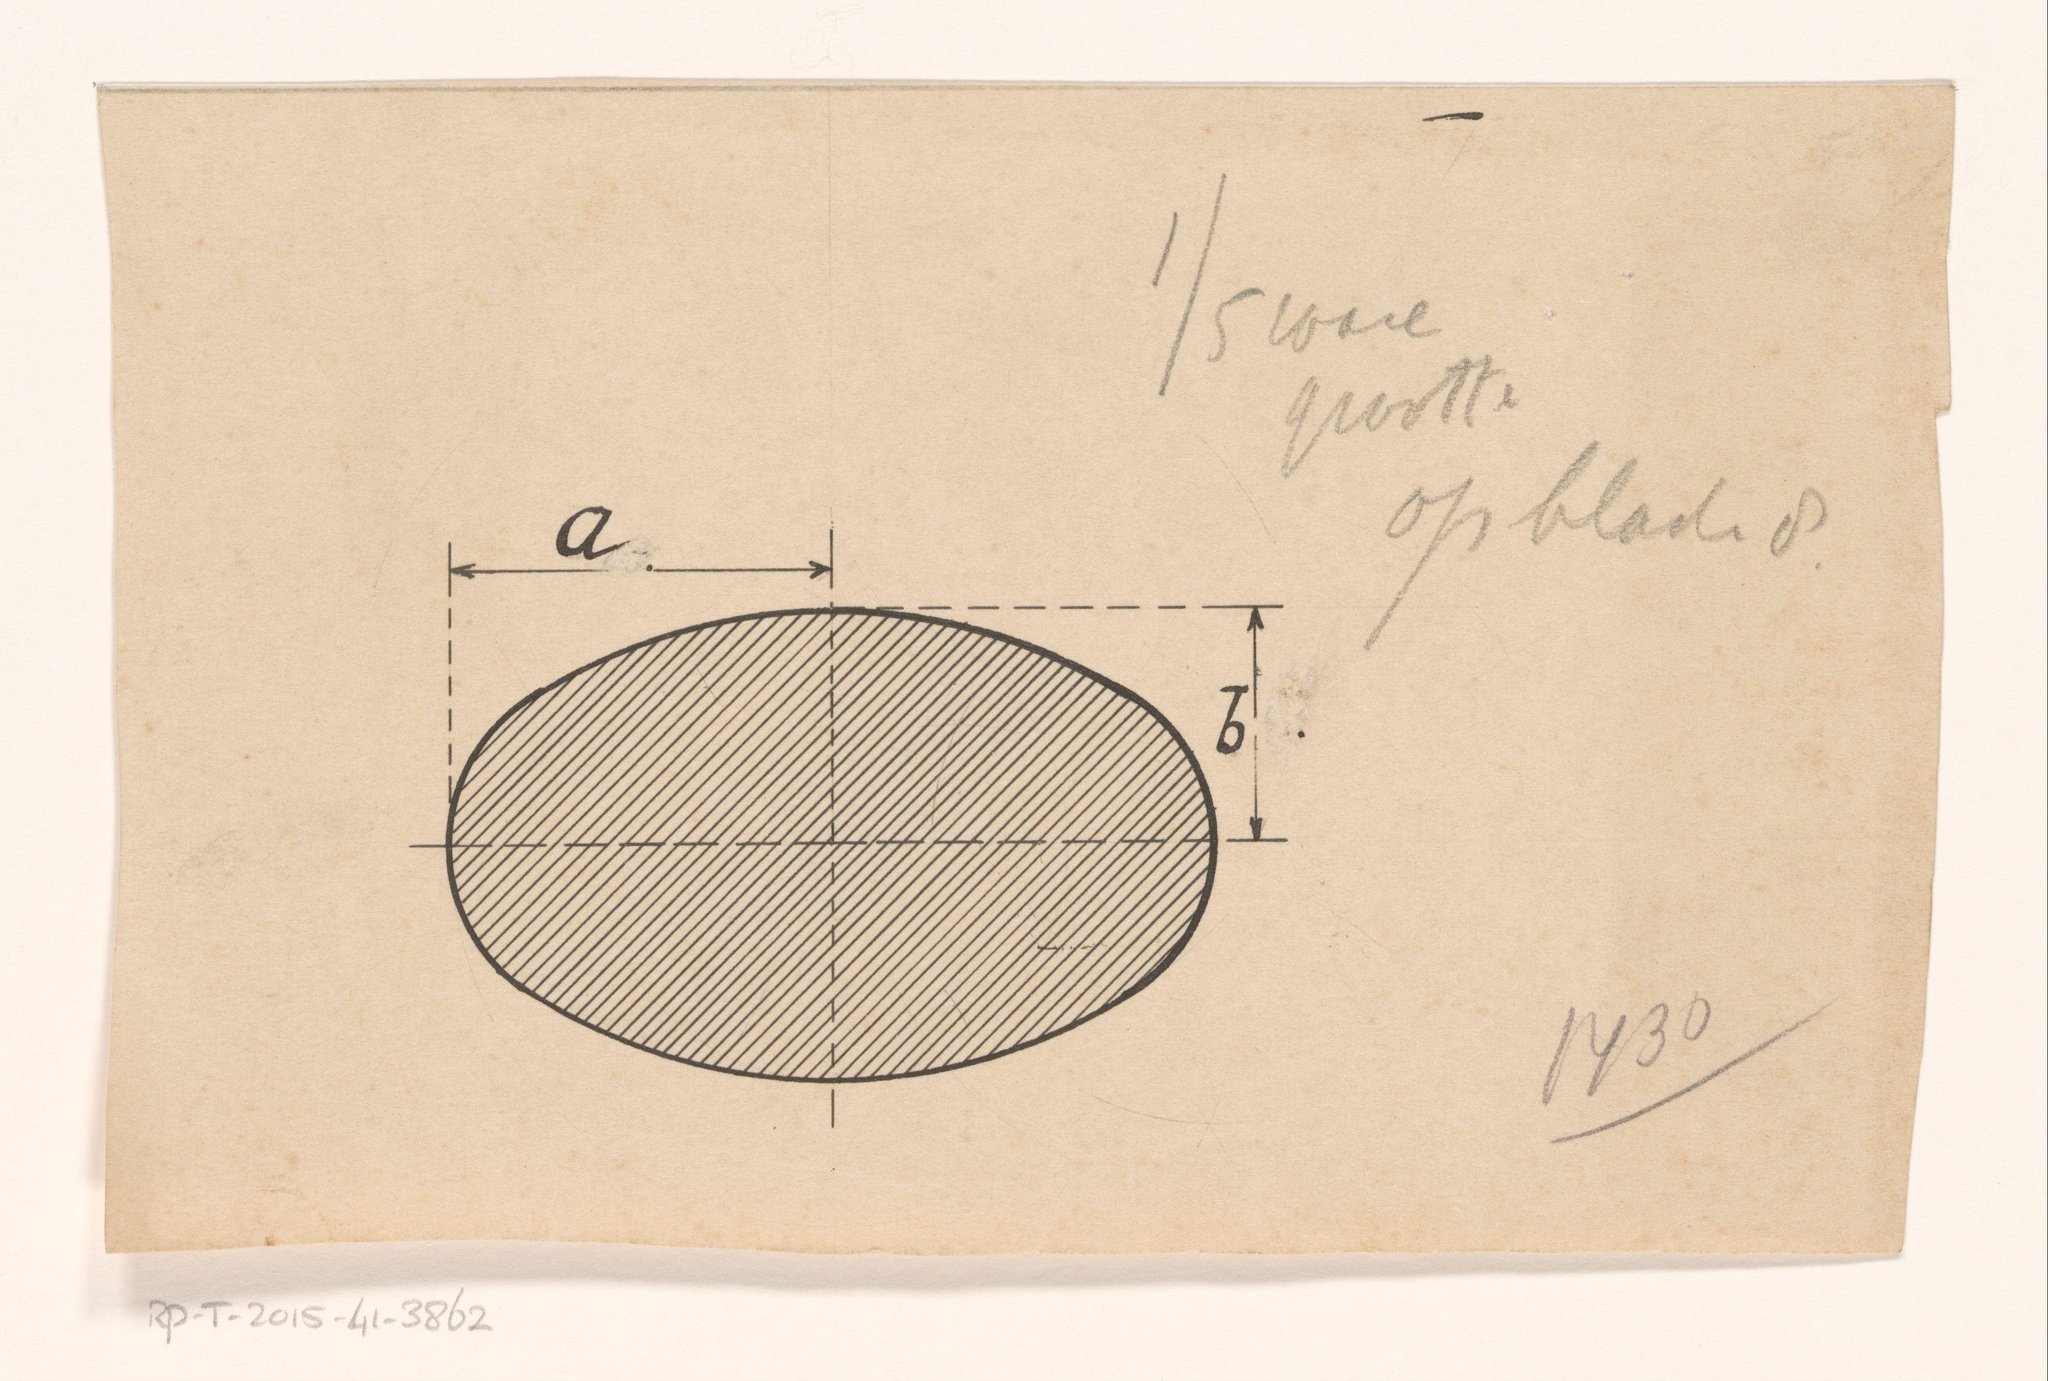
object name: boekillustratie ontwerp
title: Ovaal met meetinstructies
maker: Anonymous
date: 1880-1970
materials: ink, paper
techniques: pen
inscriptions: clichéaanwijzing, recto, handgeschreven